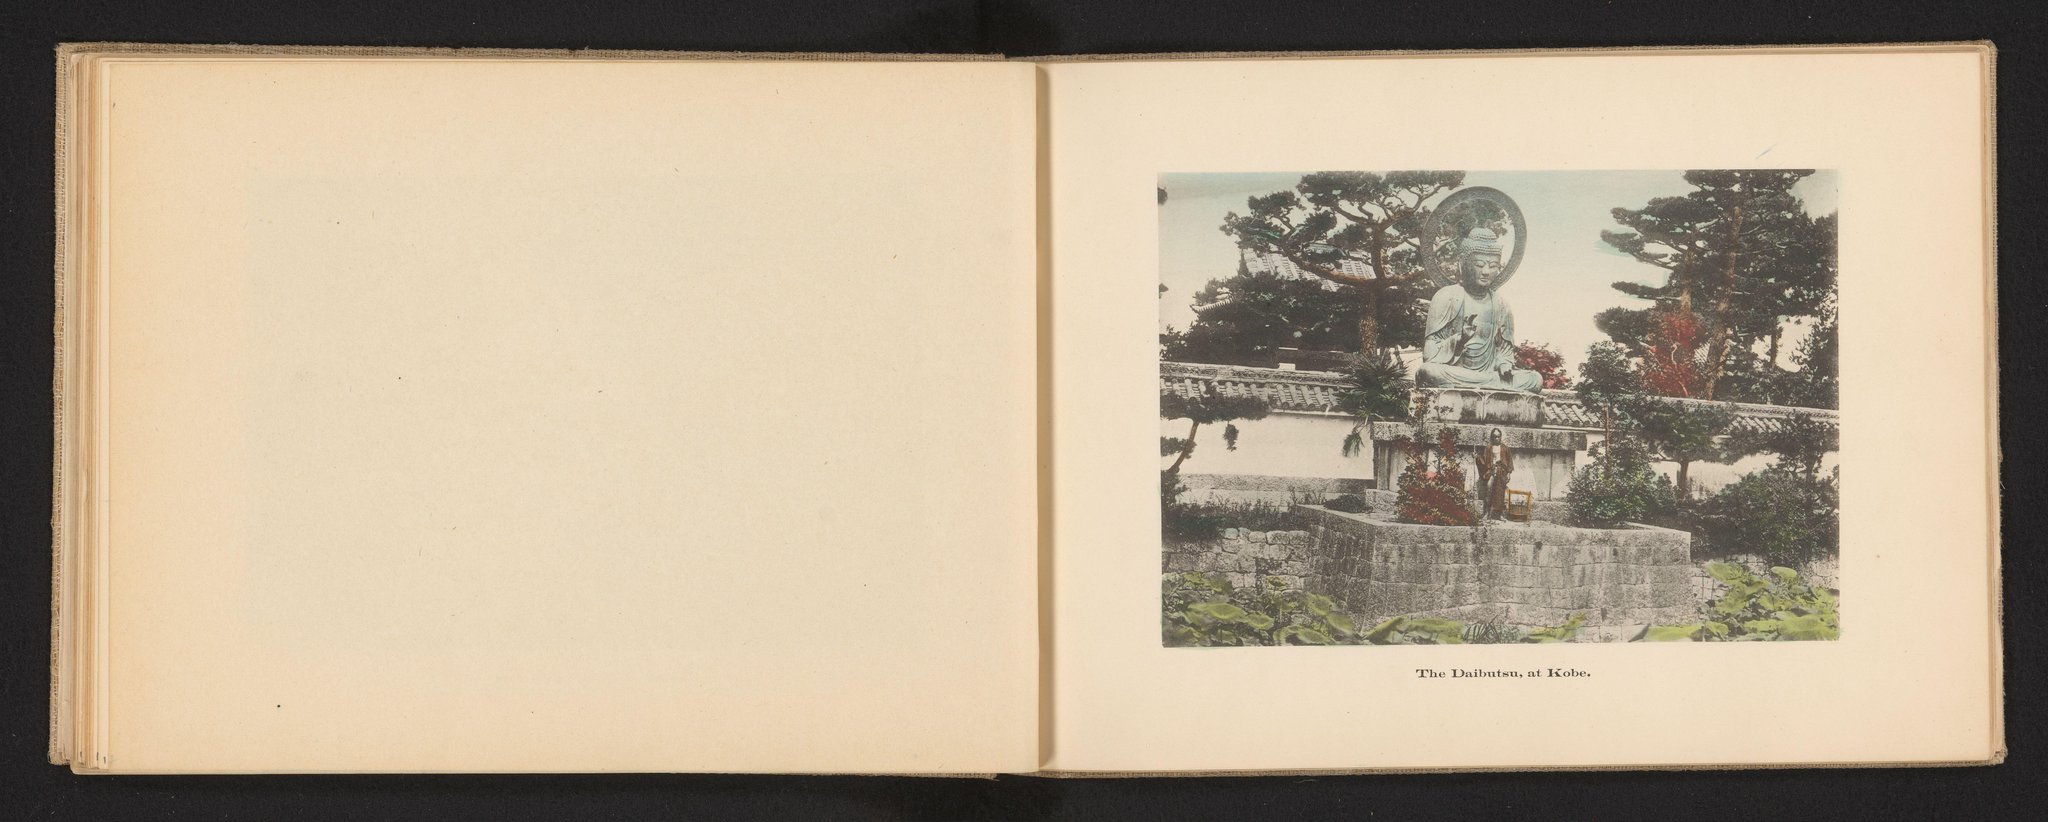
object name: photomechanical print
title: Gezicht op de Daibutsu van Kobe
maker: kōzaburō tamamura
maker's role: fotograaf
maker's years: 1856-1923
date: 1895-1905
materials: paper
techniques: photograph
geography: kobe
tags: buddha, founder of buddhism